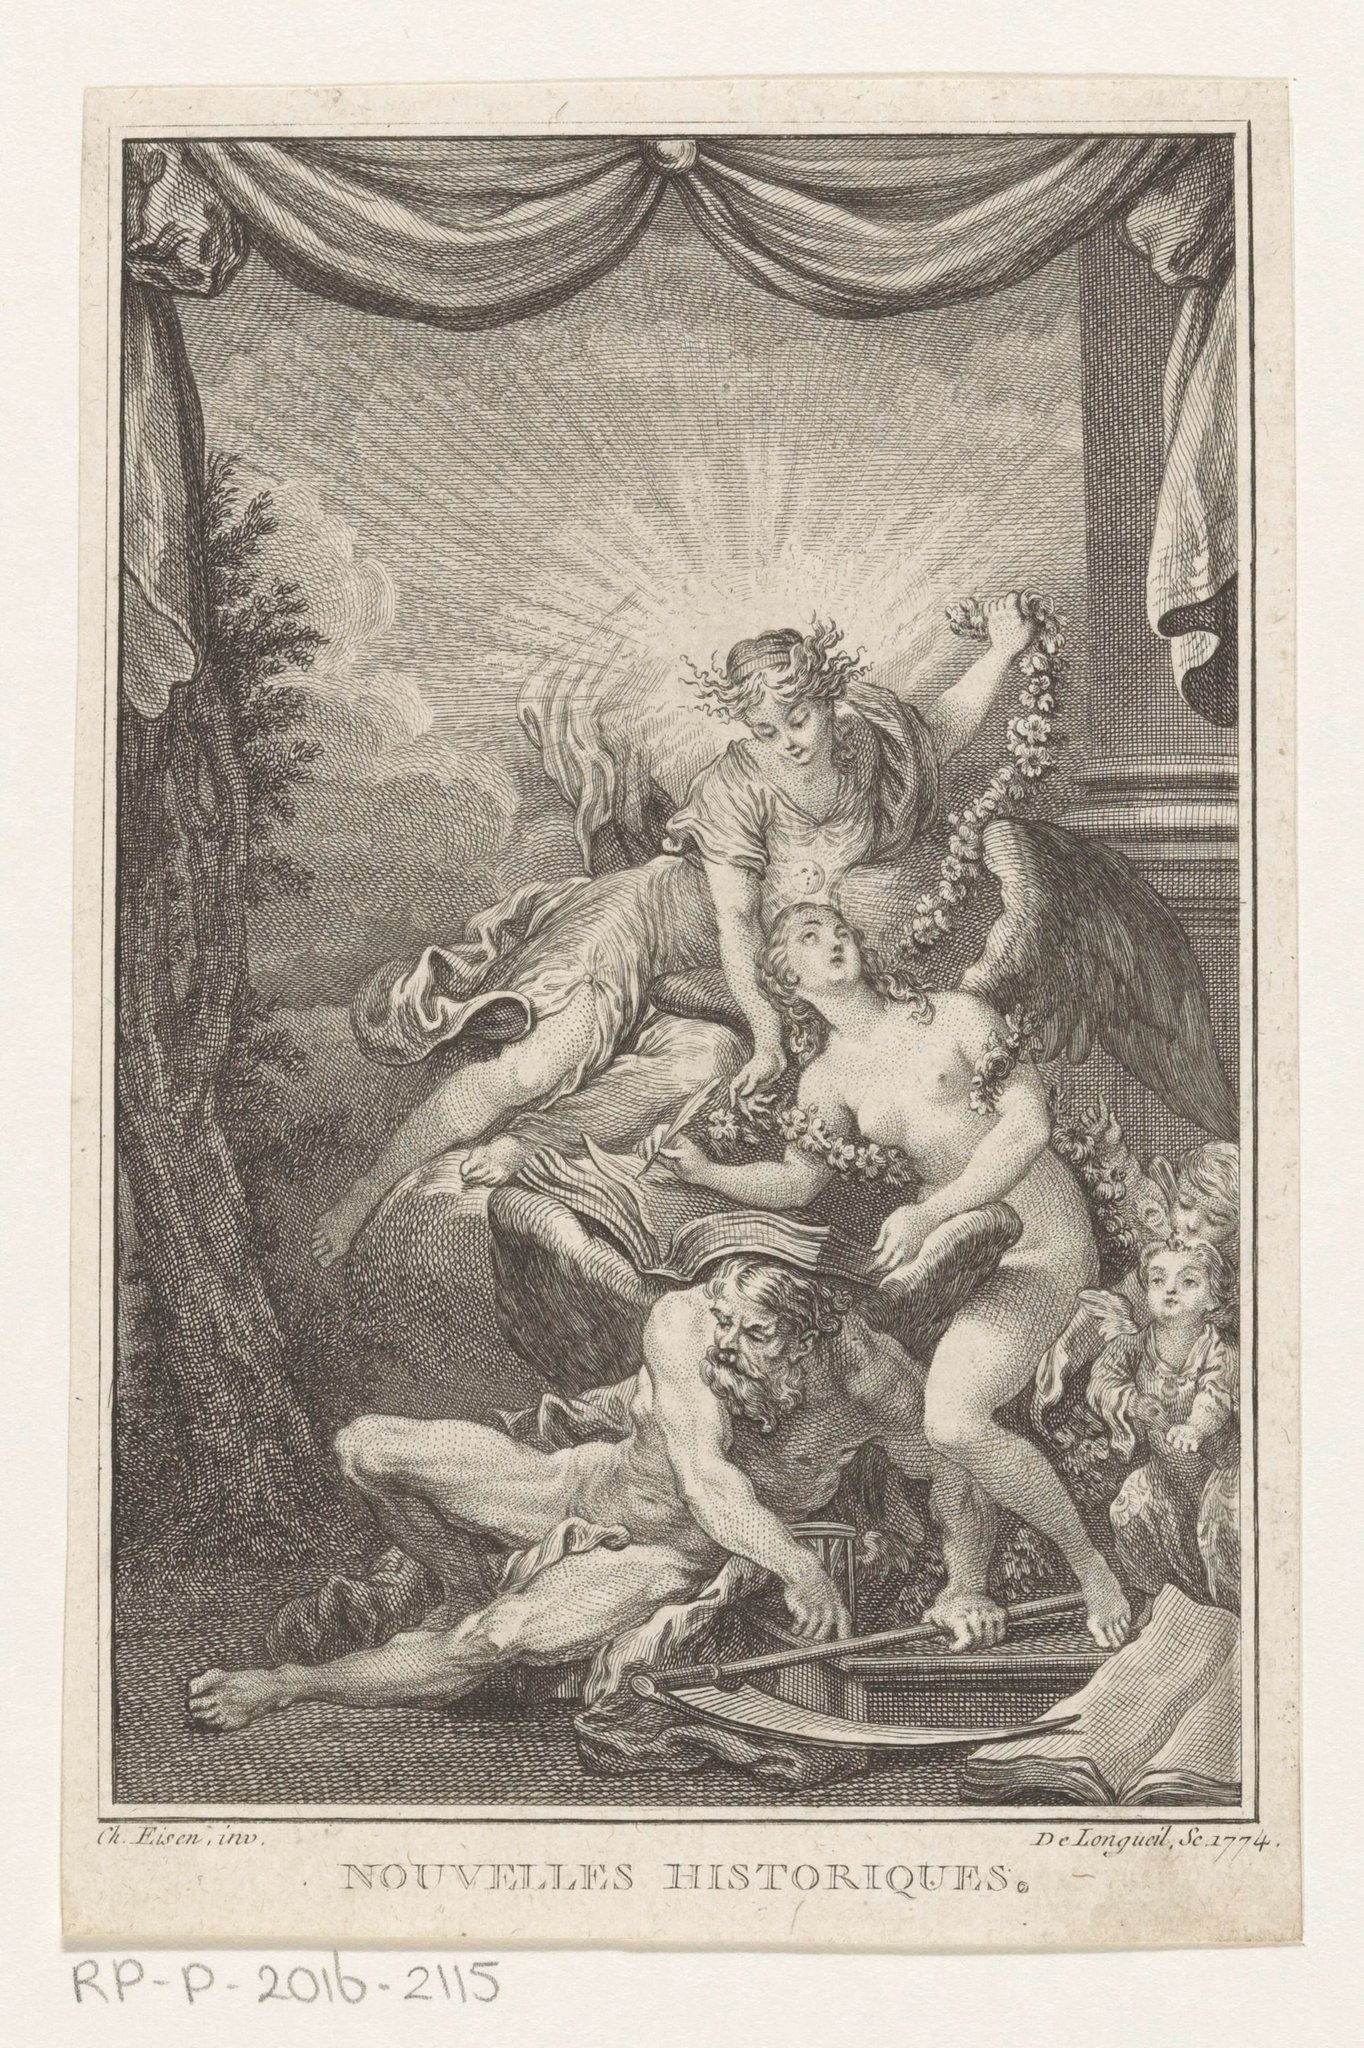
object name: titelblad, titelpagina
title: Waarheid schrijft geschiedenis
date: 1774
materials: paper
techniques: engraving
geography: paris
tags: truth; 'verità' (ripa), 'historia'; 'historia' (ripa), father time, man with wings and scythe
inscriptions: collector's mark: Lugt 2228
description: Titelpagina voor: Baculard d'Arnaud, François-Thomas-Marie de. Nouvelles historiques. Parijs: Delalain, Nicolas-Augustin, 1774. Prent afkomstig uit een plakalbum met titelprenten, ornamenten etc. op blauw papier in 1983 uit elkaar gehaald. Volgens een notitie op verso zat de prent op p. 159 van dit album.